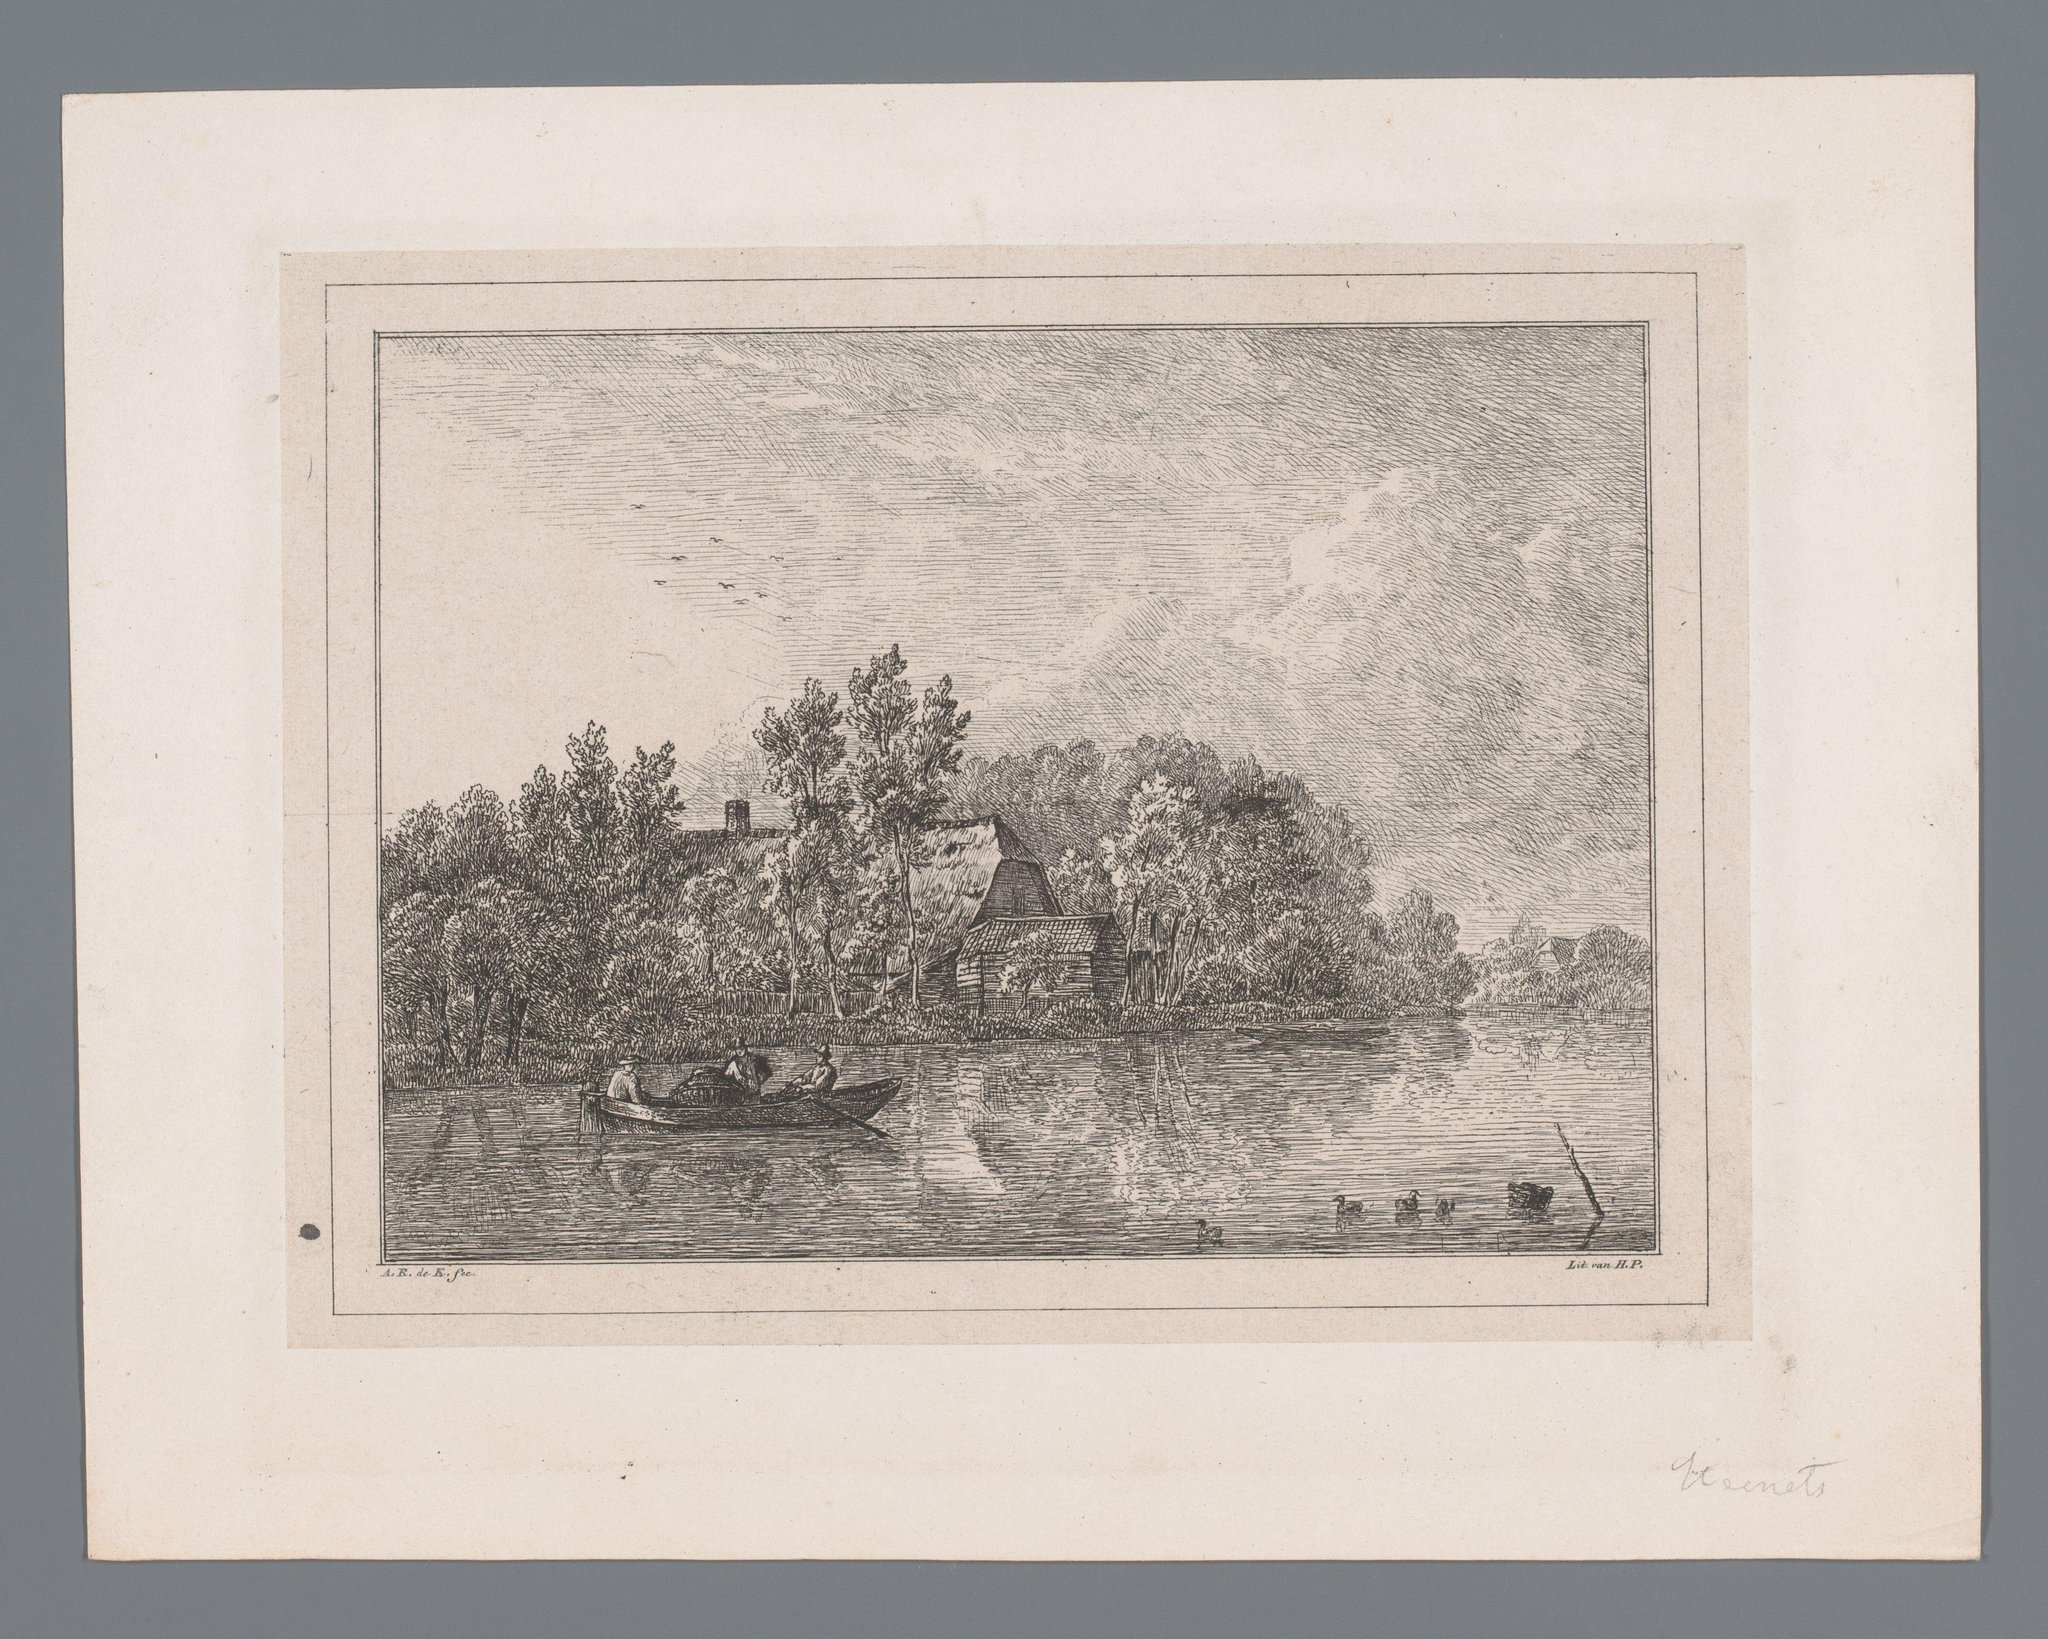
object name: print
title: Zestal gezigten in de omstreken van Dordrecht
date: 1839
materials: paper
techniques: etching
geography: dordrecht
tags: river, farm or solitary house in landscape, dordrecht